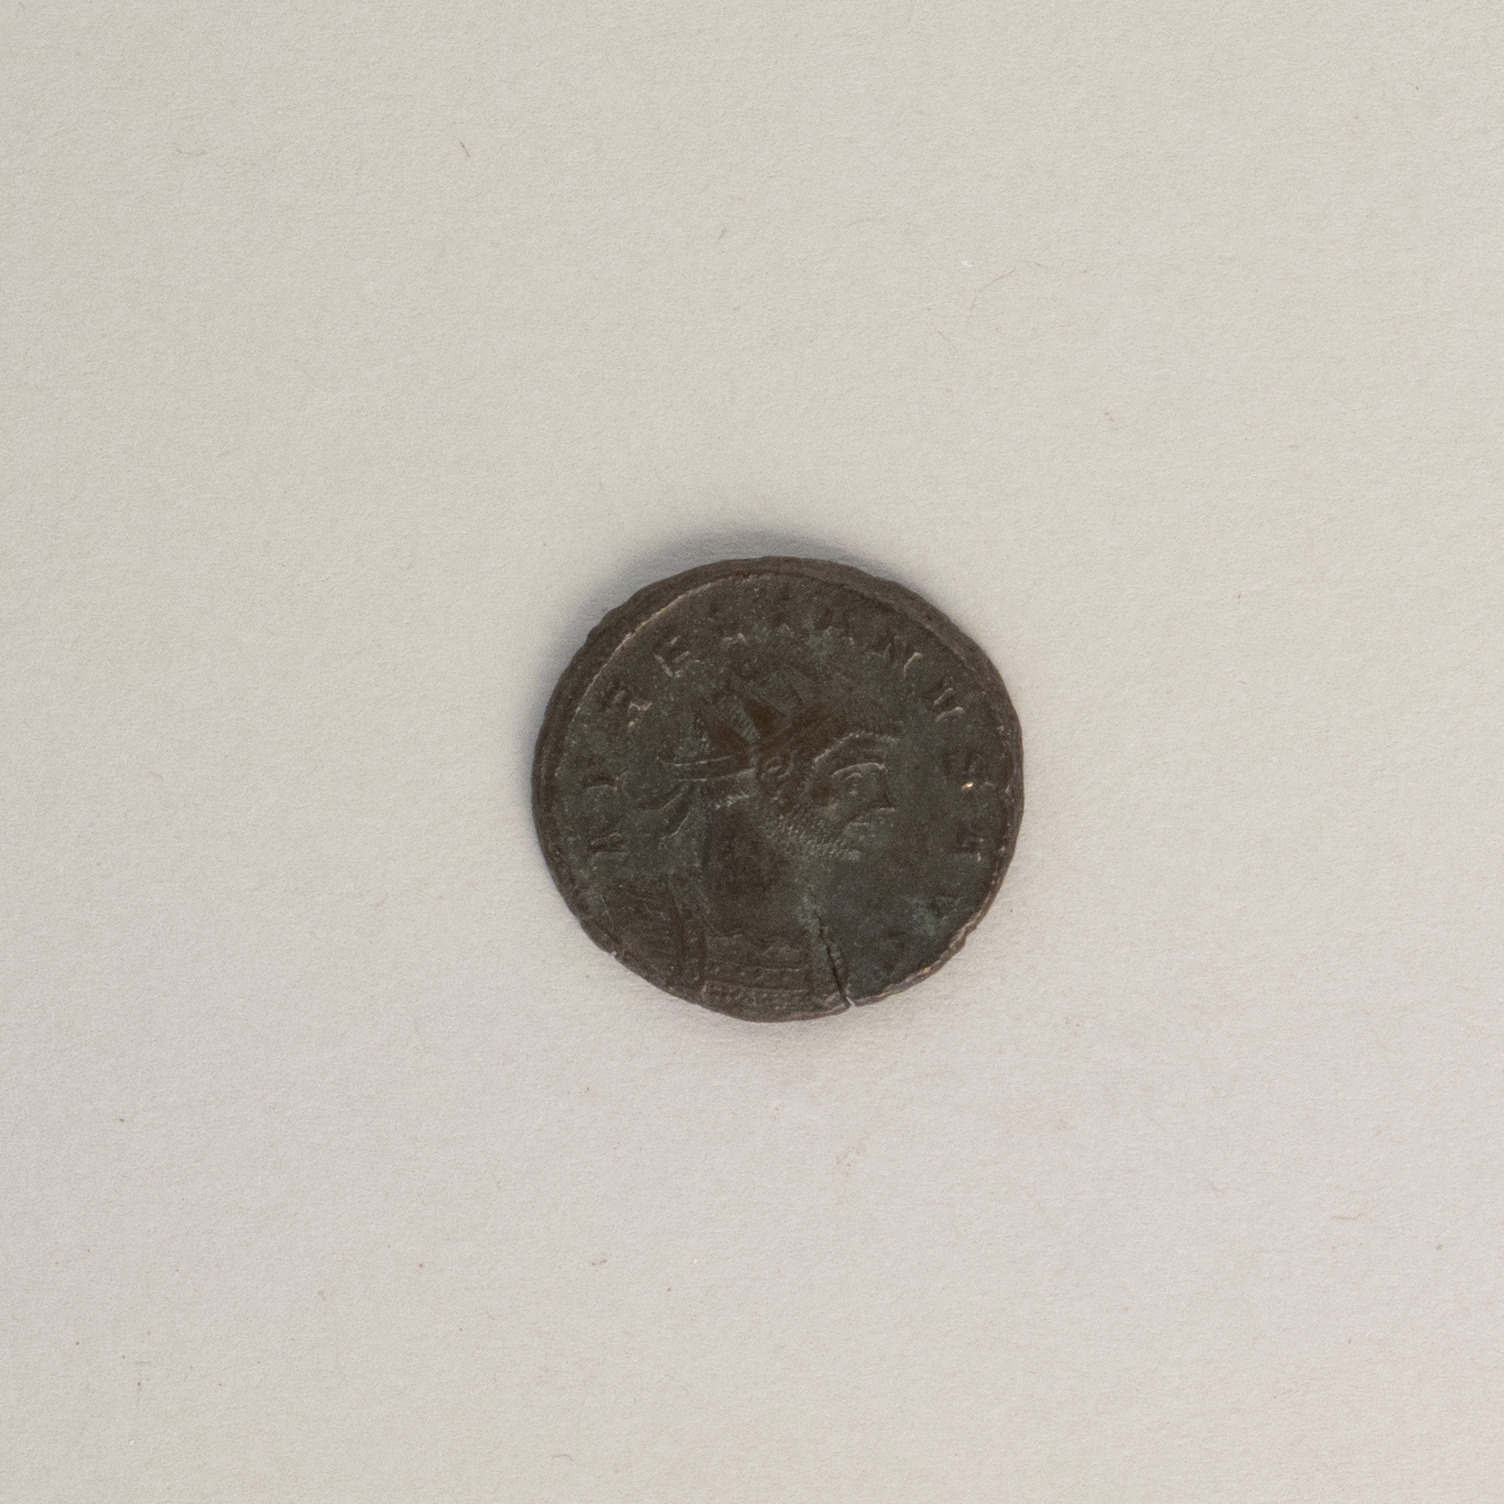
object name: antoninianus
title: Silver antoninianus of Aurelian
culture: roman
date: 270-275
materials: silver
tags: men,coins